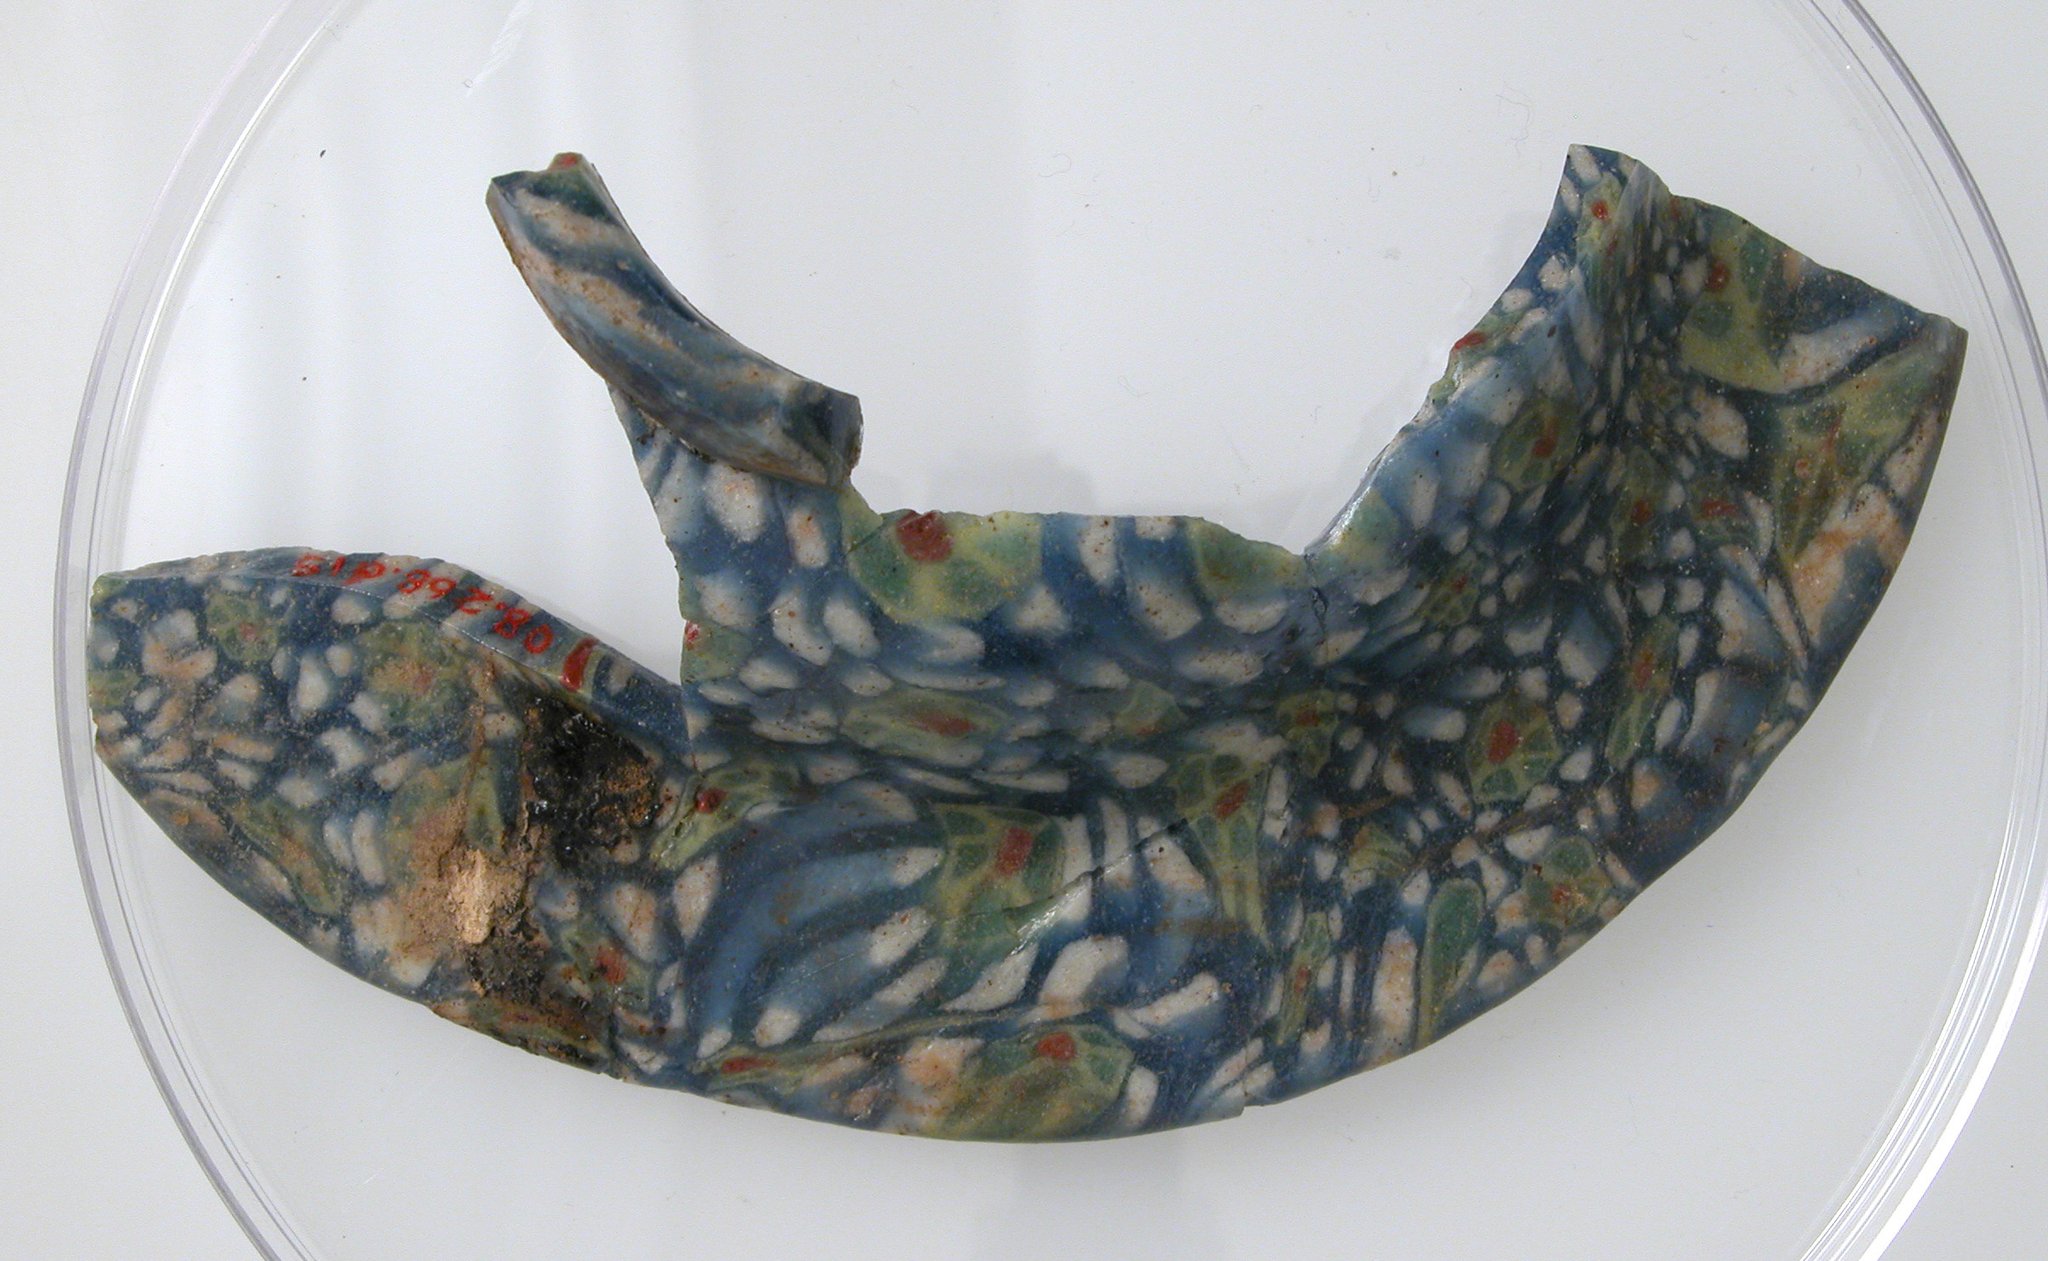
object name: fragment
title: Rim of a Vessel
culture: coptic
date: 301-433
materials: glass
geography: egypt